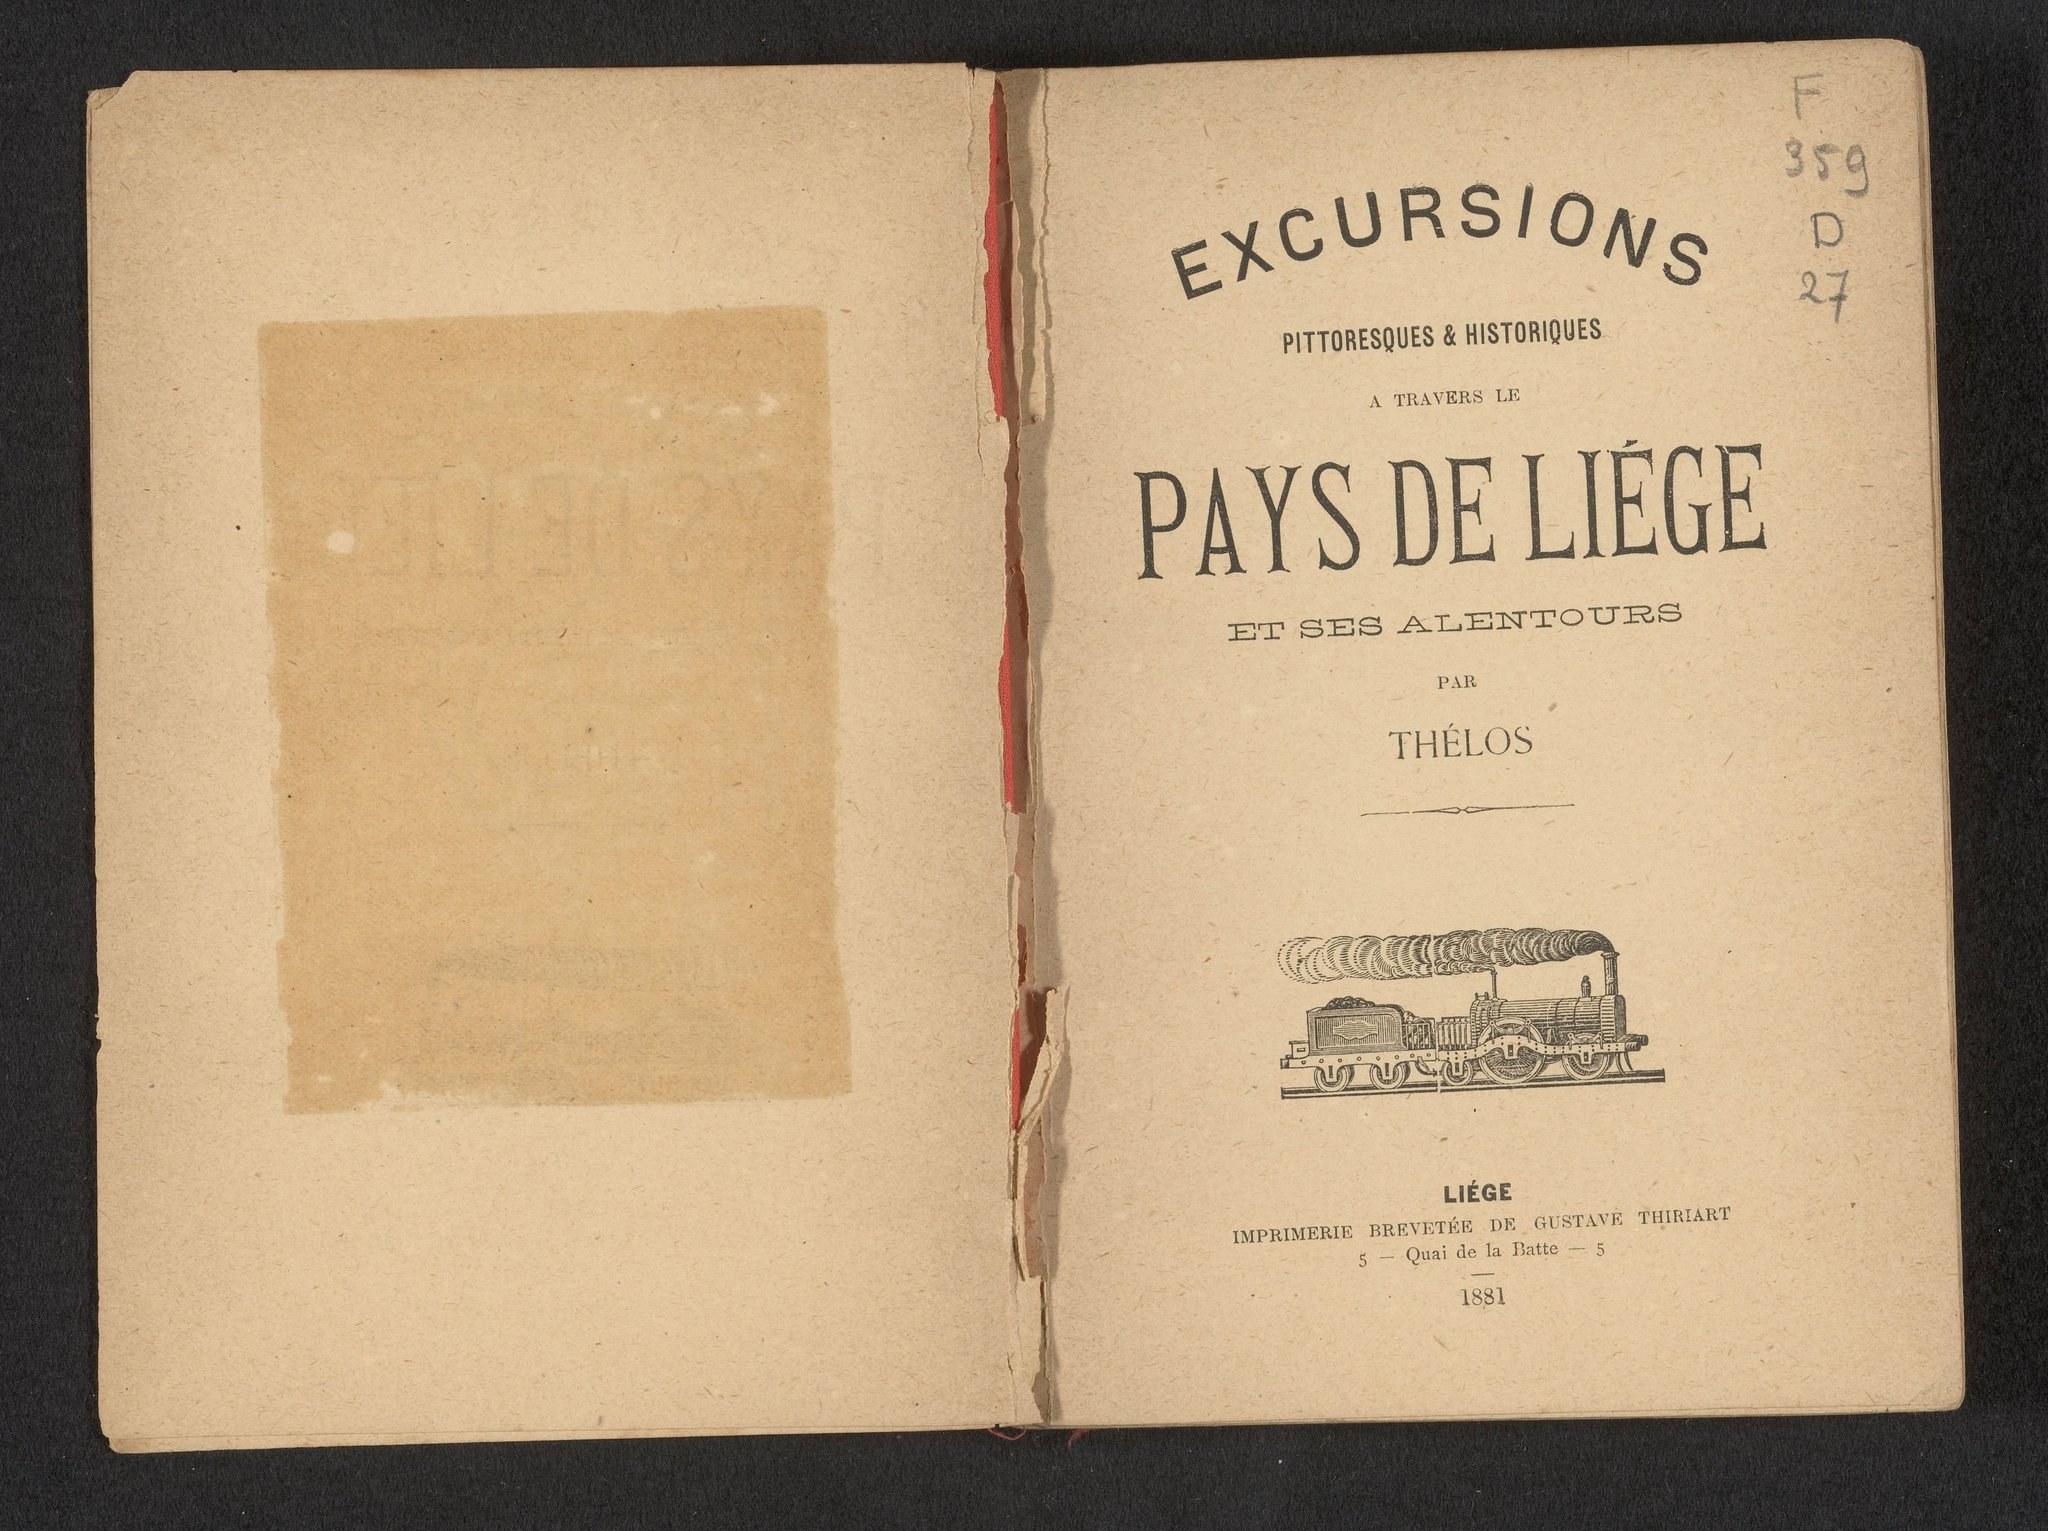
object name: book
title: Excursions pittoresques [et] historiques à travers le pays de Liége et ses alentours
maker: gustave thiriart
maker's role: printer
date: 1881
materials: linen, paper, photographic support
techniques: albumen print, printing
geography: liège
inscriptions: date: ‘May 1983’, bookplate: ‘ex libris SFJ’, annotation: ‘[LHoest]’